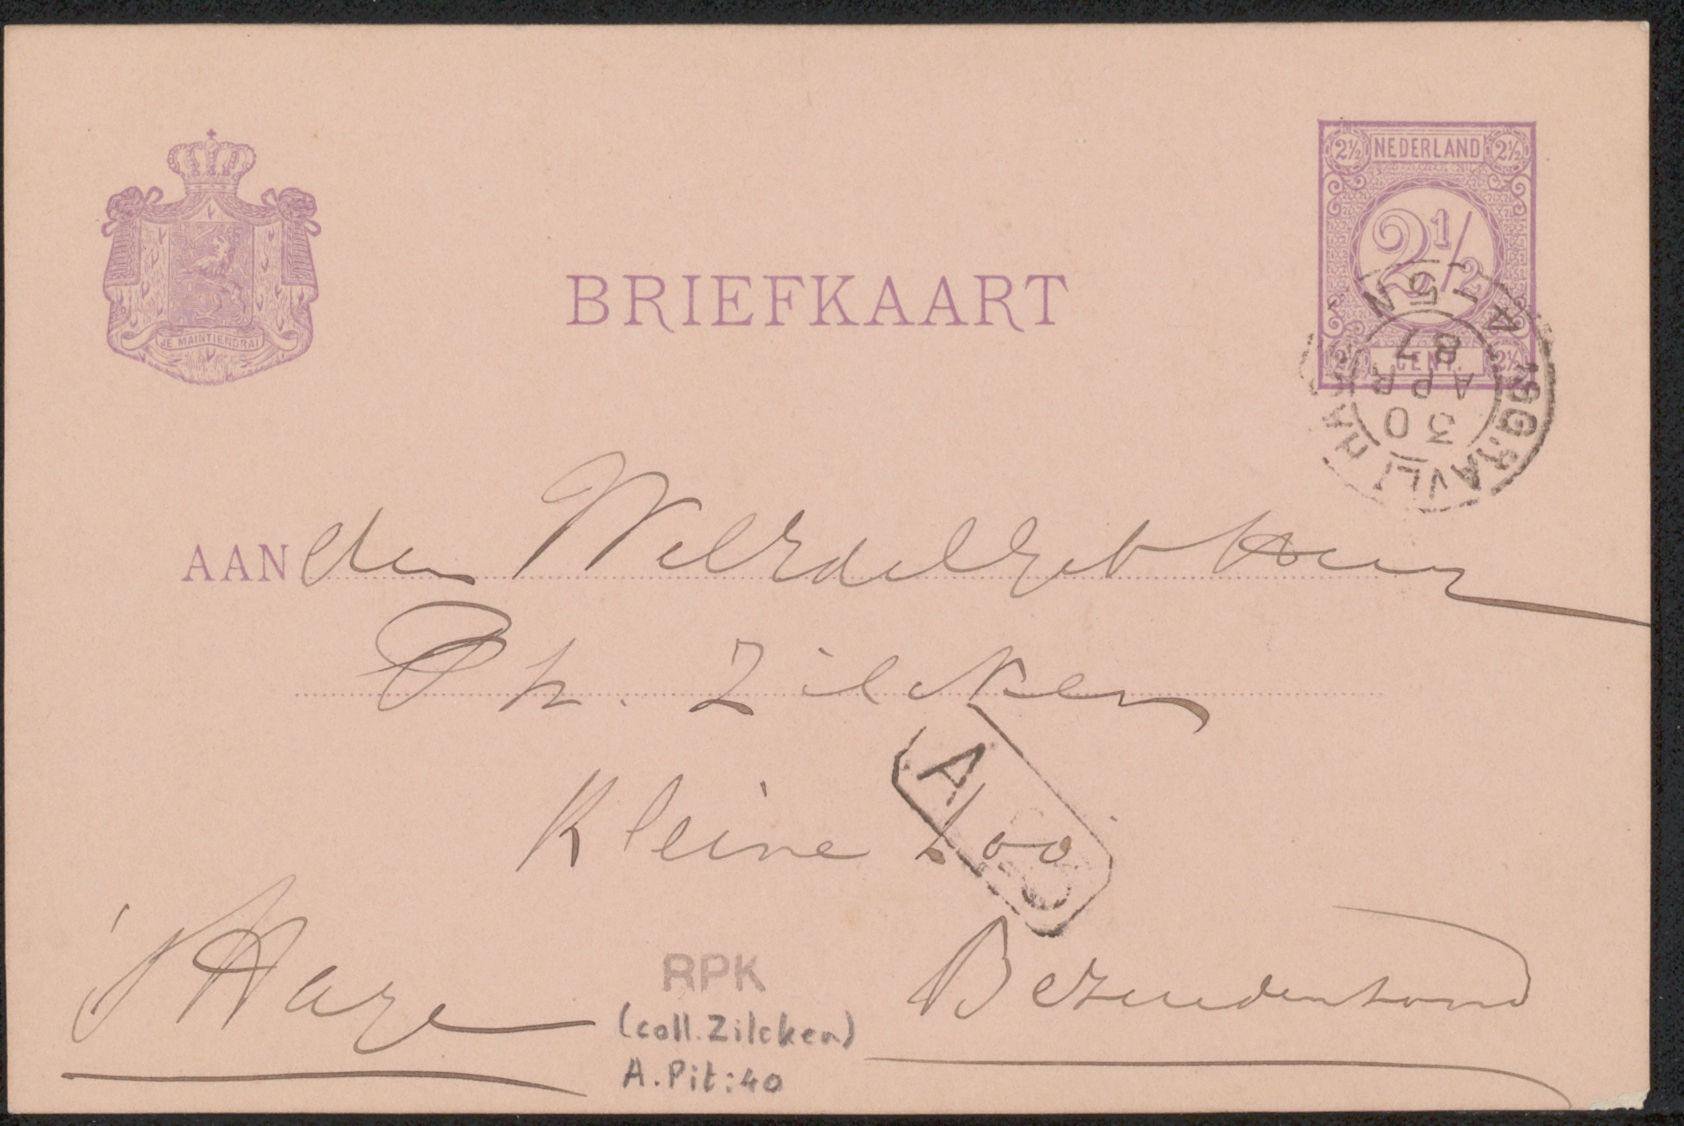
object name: postcard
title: Briefkaart aan Philip Zilcken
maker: adriaan pit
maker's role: print maker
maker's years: 1860-1944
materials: cardboard, ink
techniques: pen, writing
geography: the hague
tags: painter, draughtsman, philip zilcken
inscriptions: collector's mark: ‘RPK’